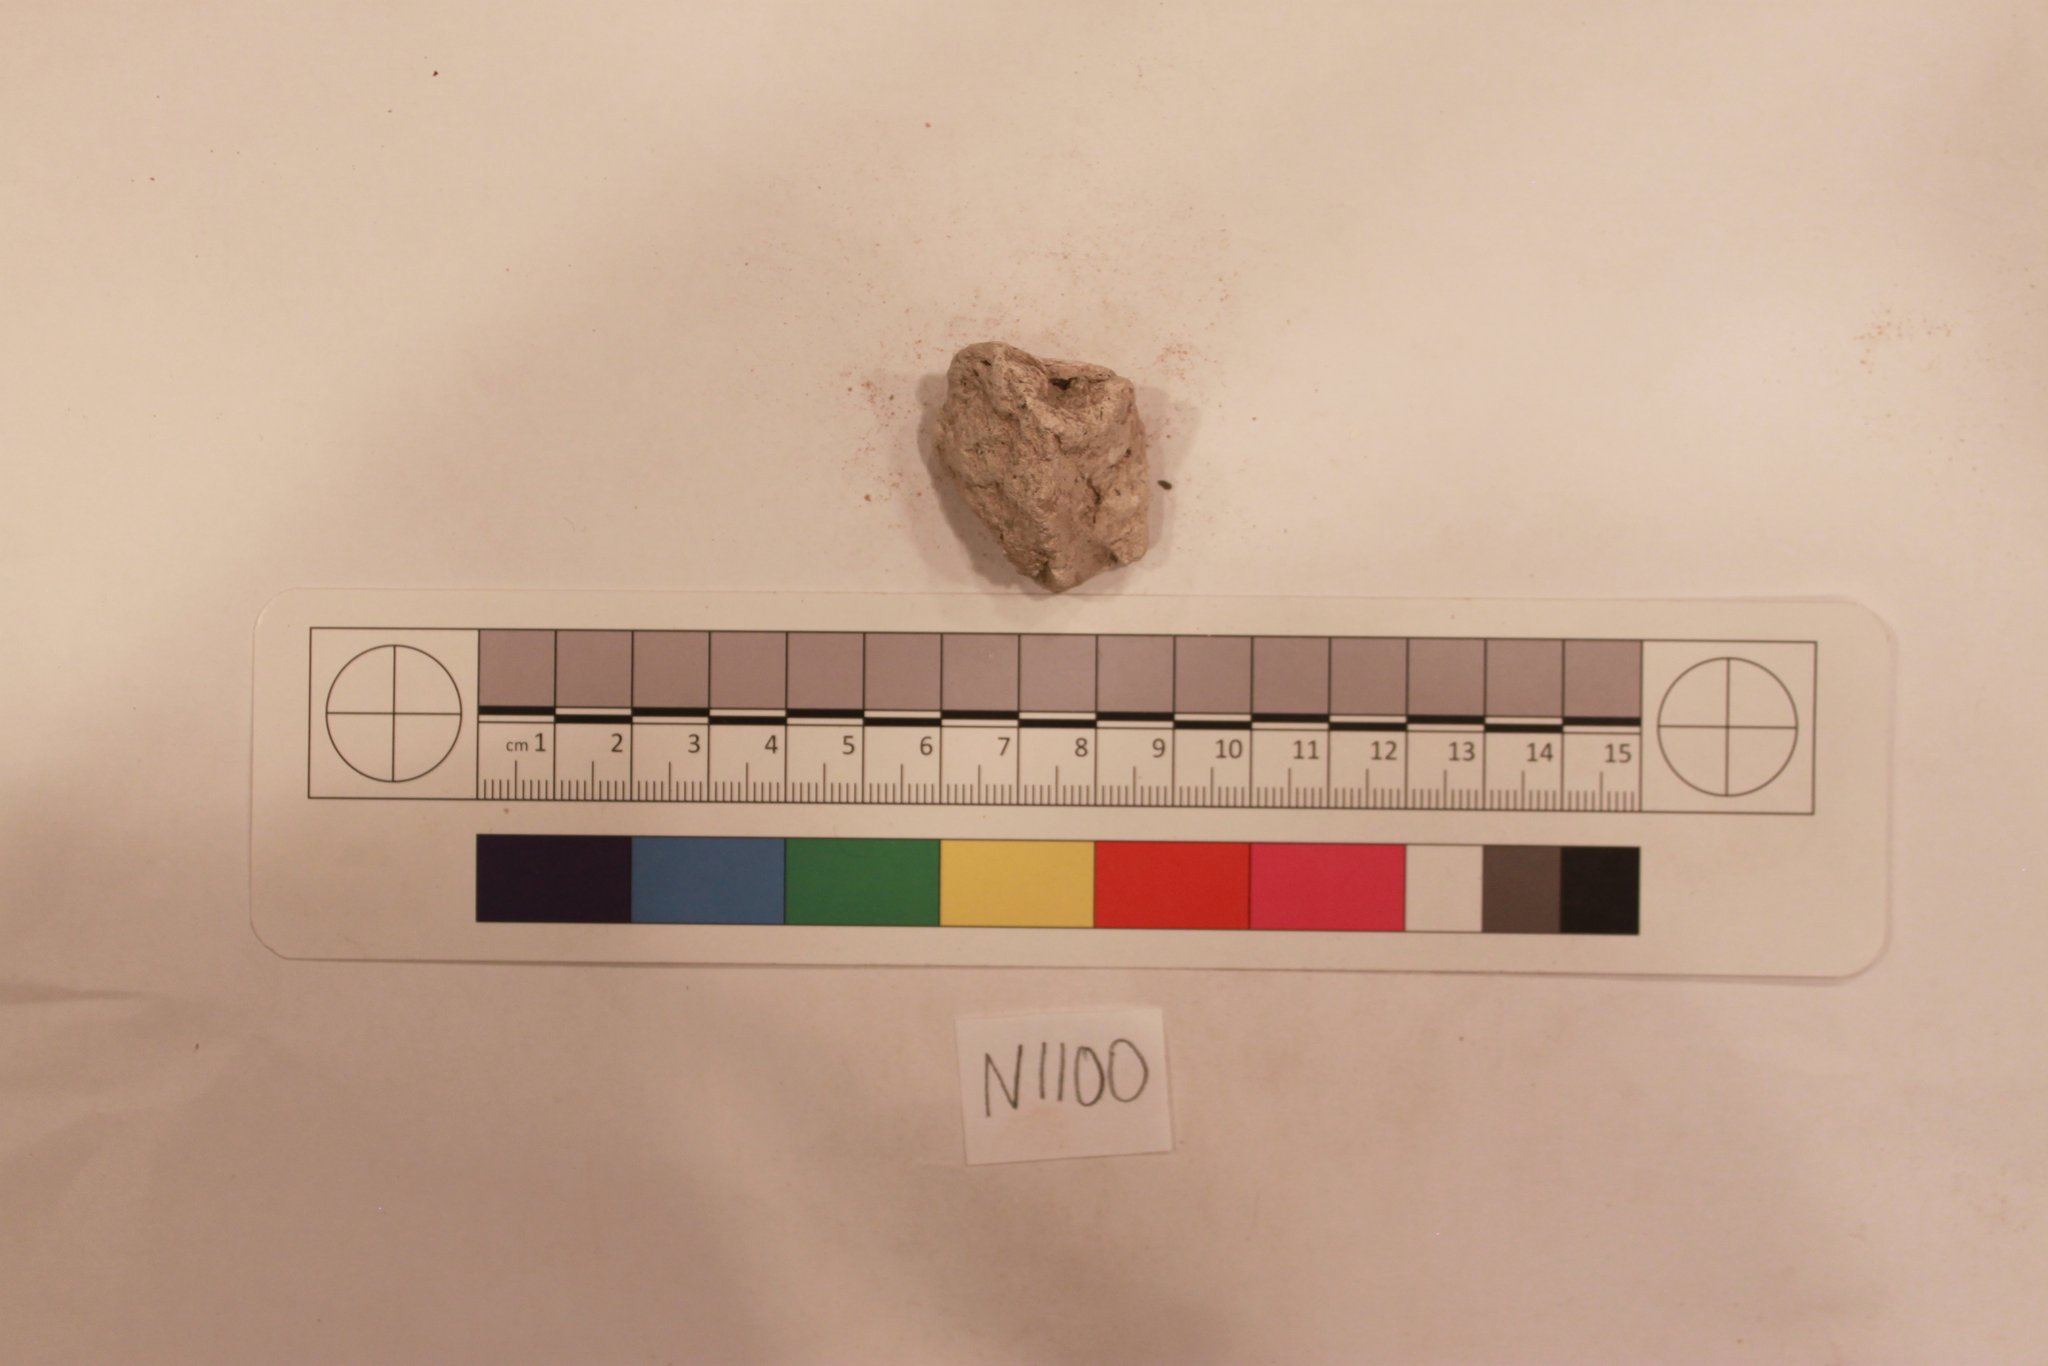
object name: fragment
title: Stucco Fragment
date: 701-1200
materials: plaster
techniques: carving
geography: iran